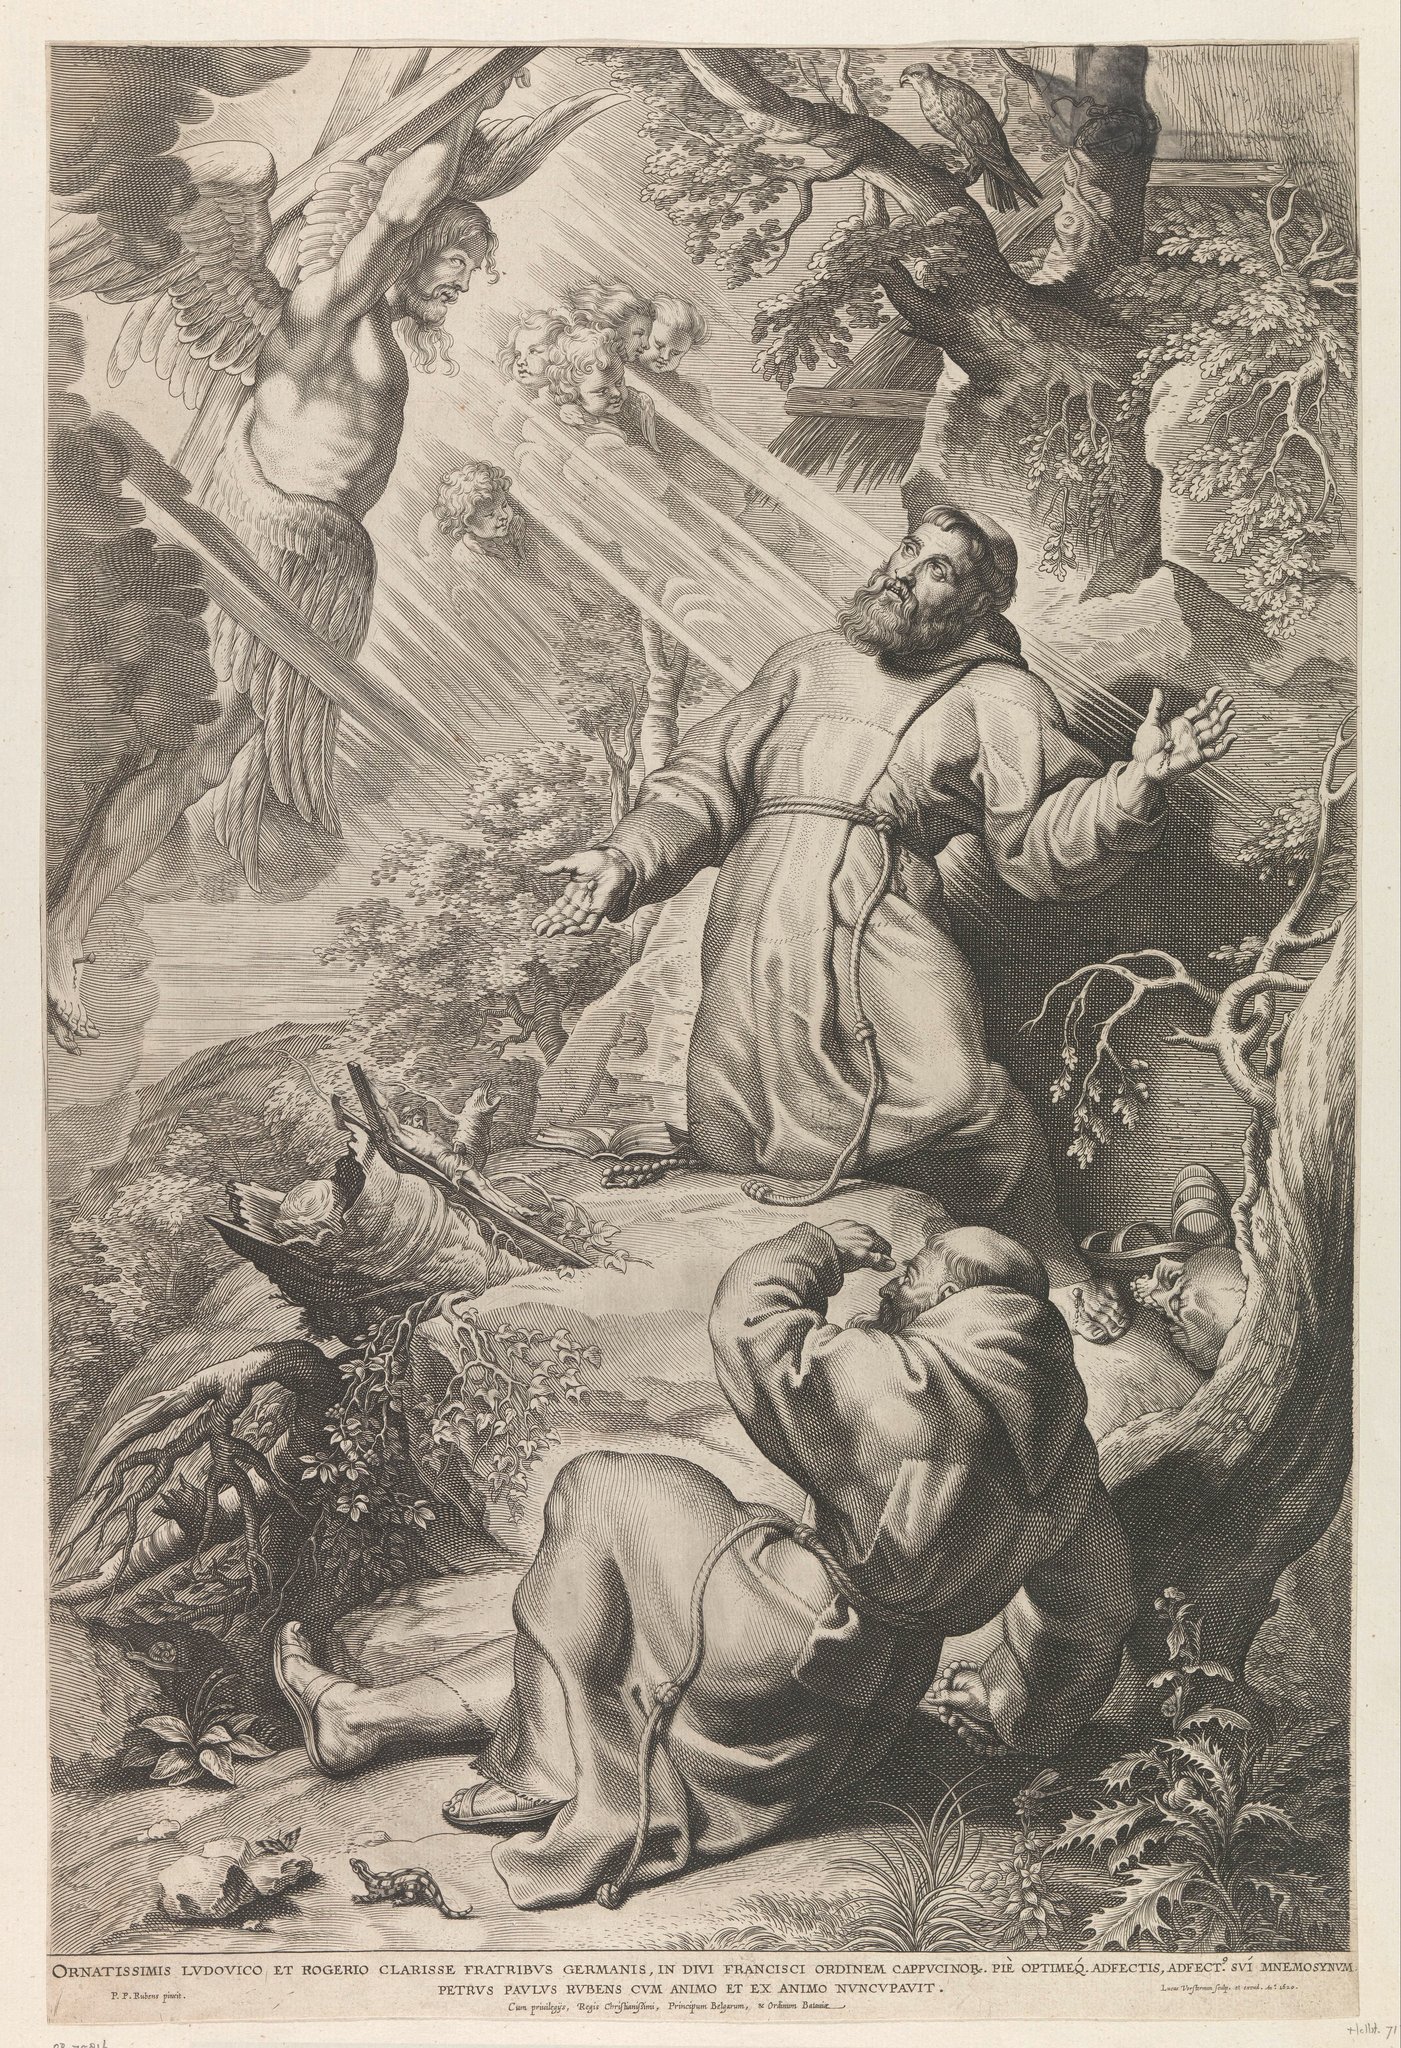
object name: album leaf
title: H. Franciscus ontvangt de stigmata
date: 1620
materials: paper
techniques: engraving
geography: antwerp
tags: founder of the order of friars minor (franciscans), francis(cus) of assisi; possible attributes: book, crucifix, lily, skull, stigmata - portrait of male saint, stigmatization, stigmata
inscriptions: date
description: De heilige Franciscus van Assisi ontvangt de stigmata. Franciscus zit geknield en heeft beide armen uitgestoken, met de wonden in zijn handpalmen. Rechts van hem liggen zijn sandalen en een schedel. De gekruisigde Christus verschijnt voor hem als een serafijn, met drie paar vleugels, naast hem in de lucht cherubijnen. Op de voorgrond zit broeder Leo, Franciscus' metgezel. Deze prent maakt deel uit van een album.